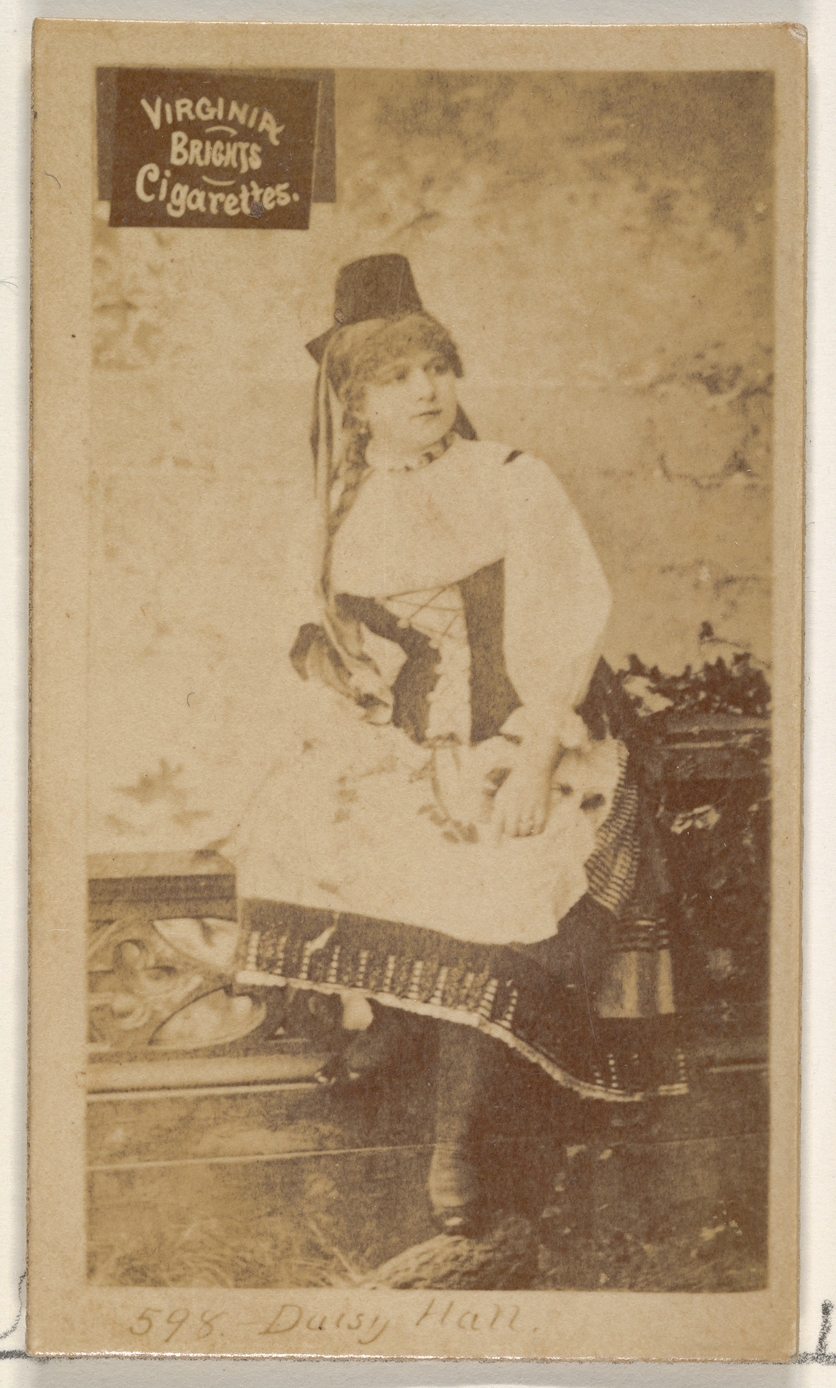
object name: photograph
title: Card 598, Daisy Hall, from the Actors and Actresses series (N45, Type 2) for Virginia Brights Cigarettes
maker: allen & ginter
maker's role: publisher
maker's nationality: american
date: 1888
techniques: albumen silver print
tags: portraits,women,actresses